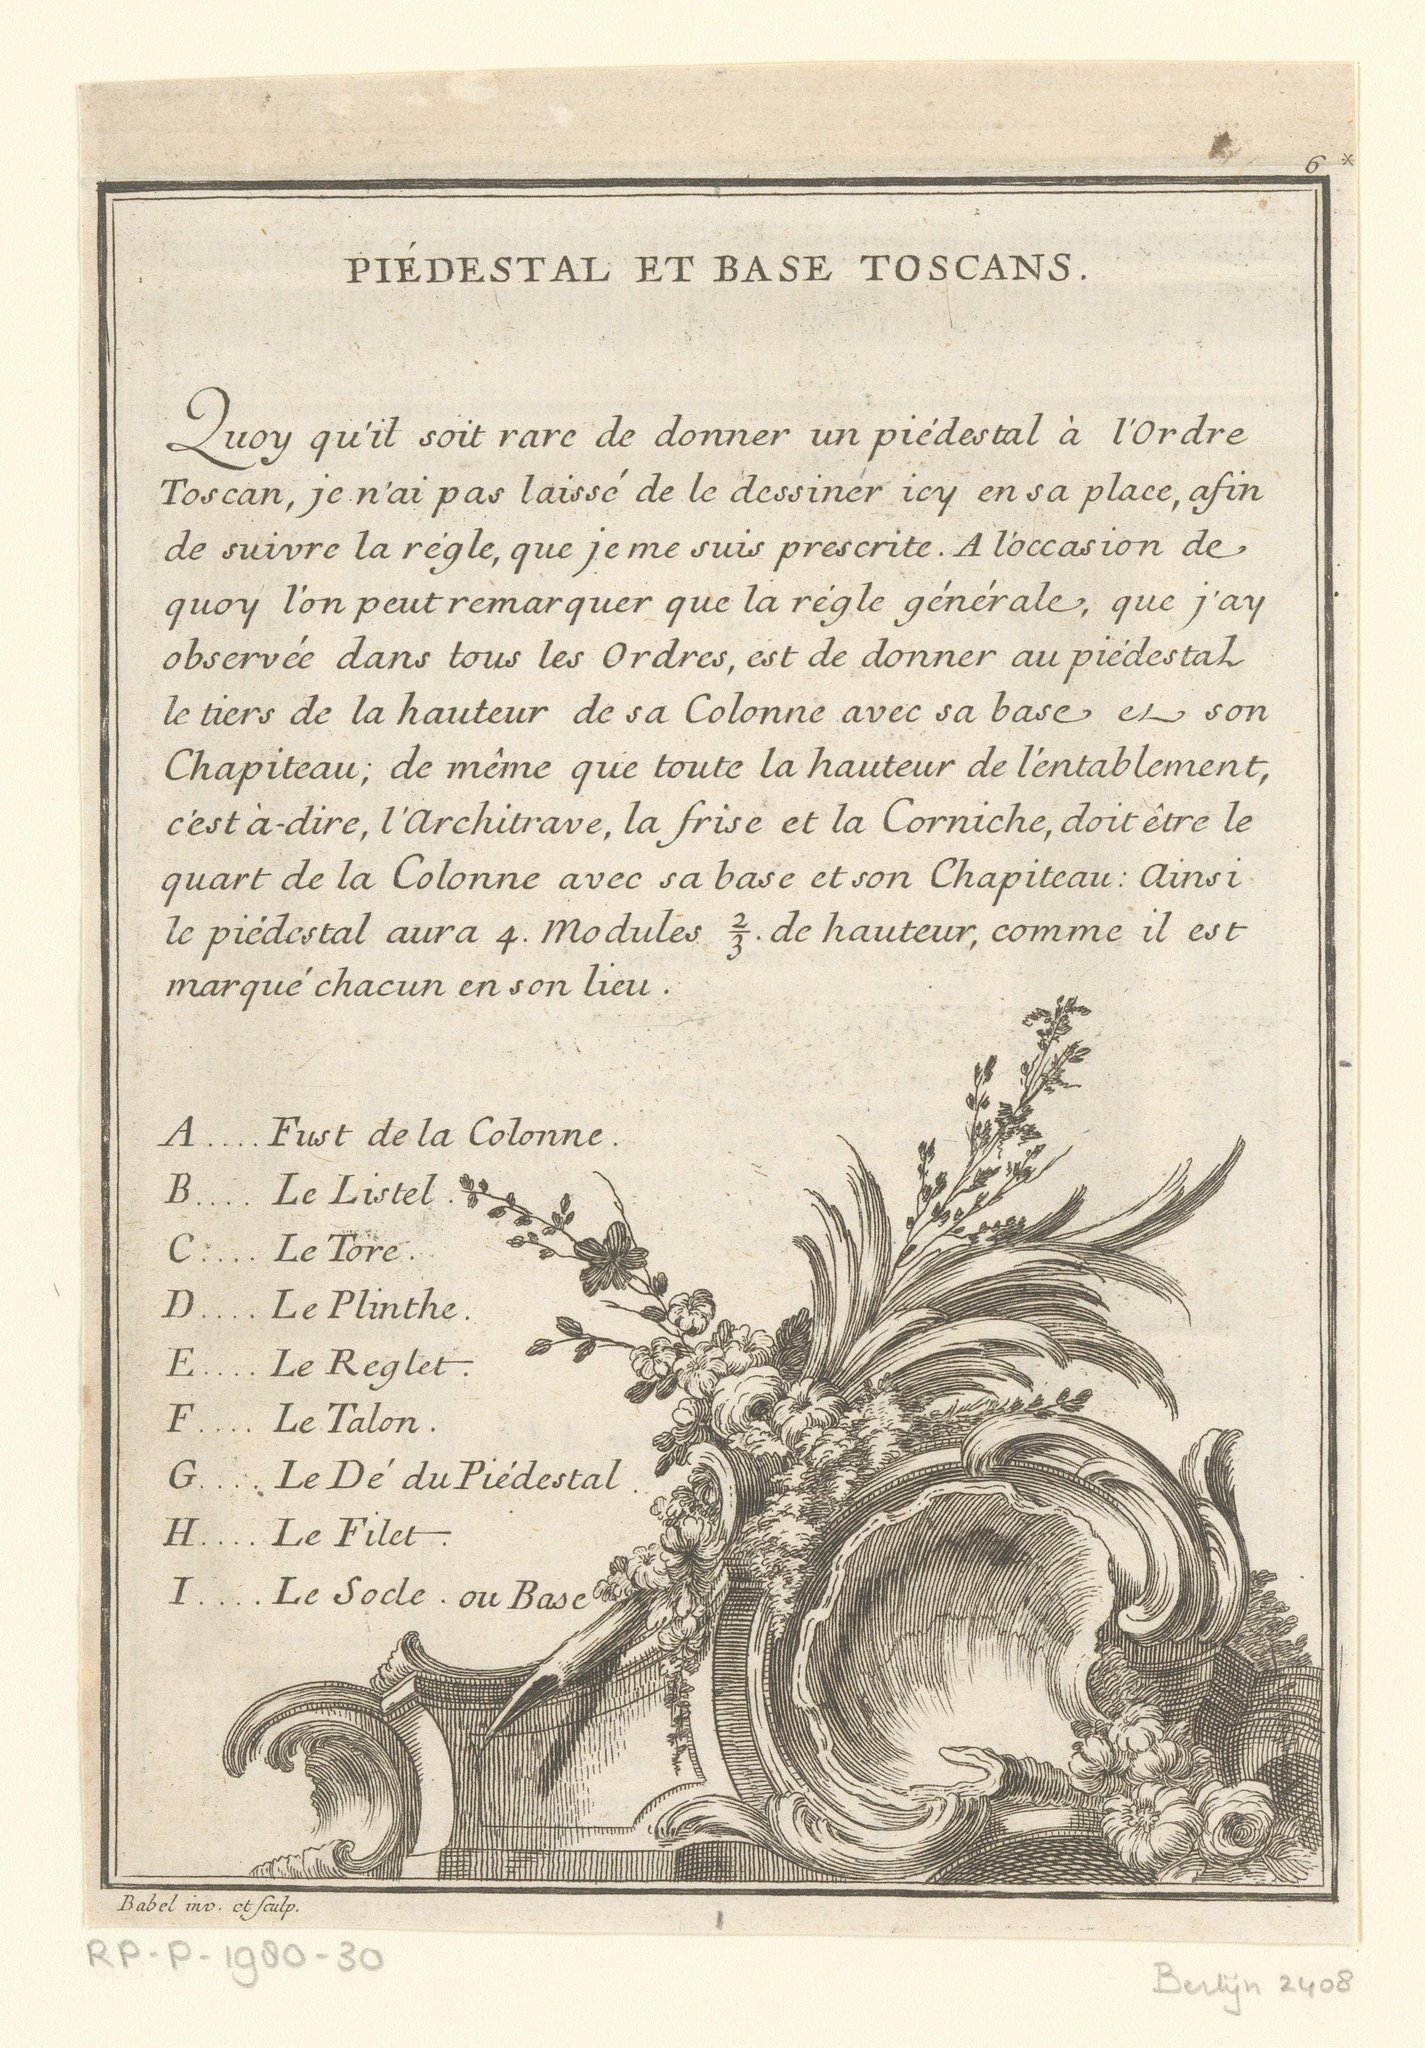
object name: print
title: Piédestal et base toscans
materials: paper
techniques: etching, letterpress printing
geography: paris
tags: ornaments ~ art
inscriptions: collector's mark: Lugt 2228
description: Pagina 6 uit: Babel, Pierre Edme. Le Nouveau Vignole ou Regles Des Cinq Ordres D'Architecture (...). Parijs: Chereau, François (II), 1755.